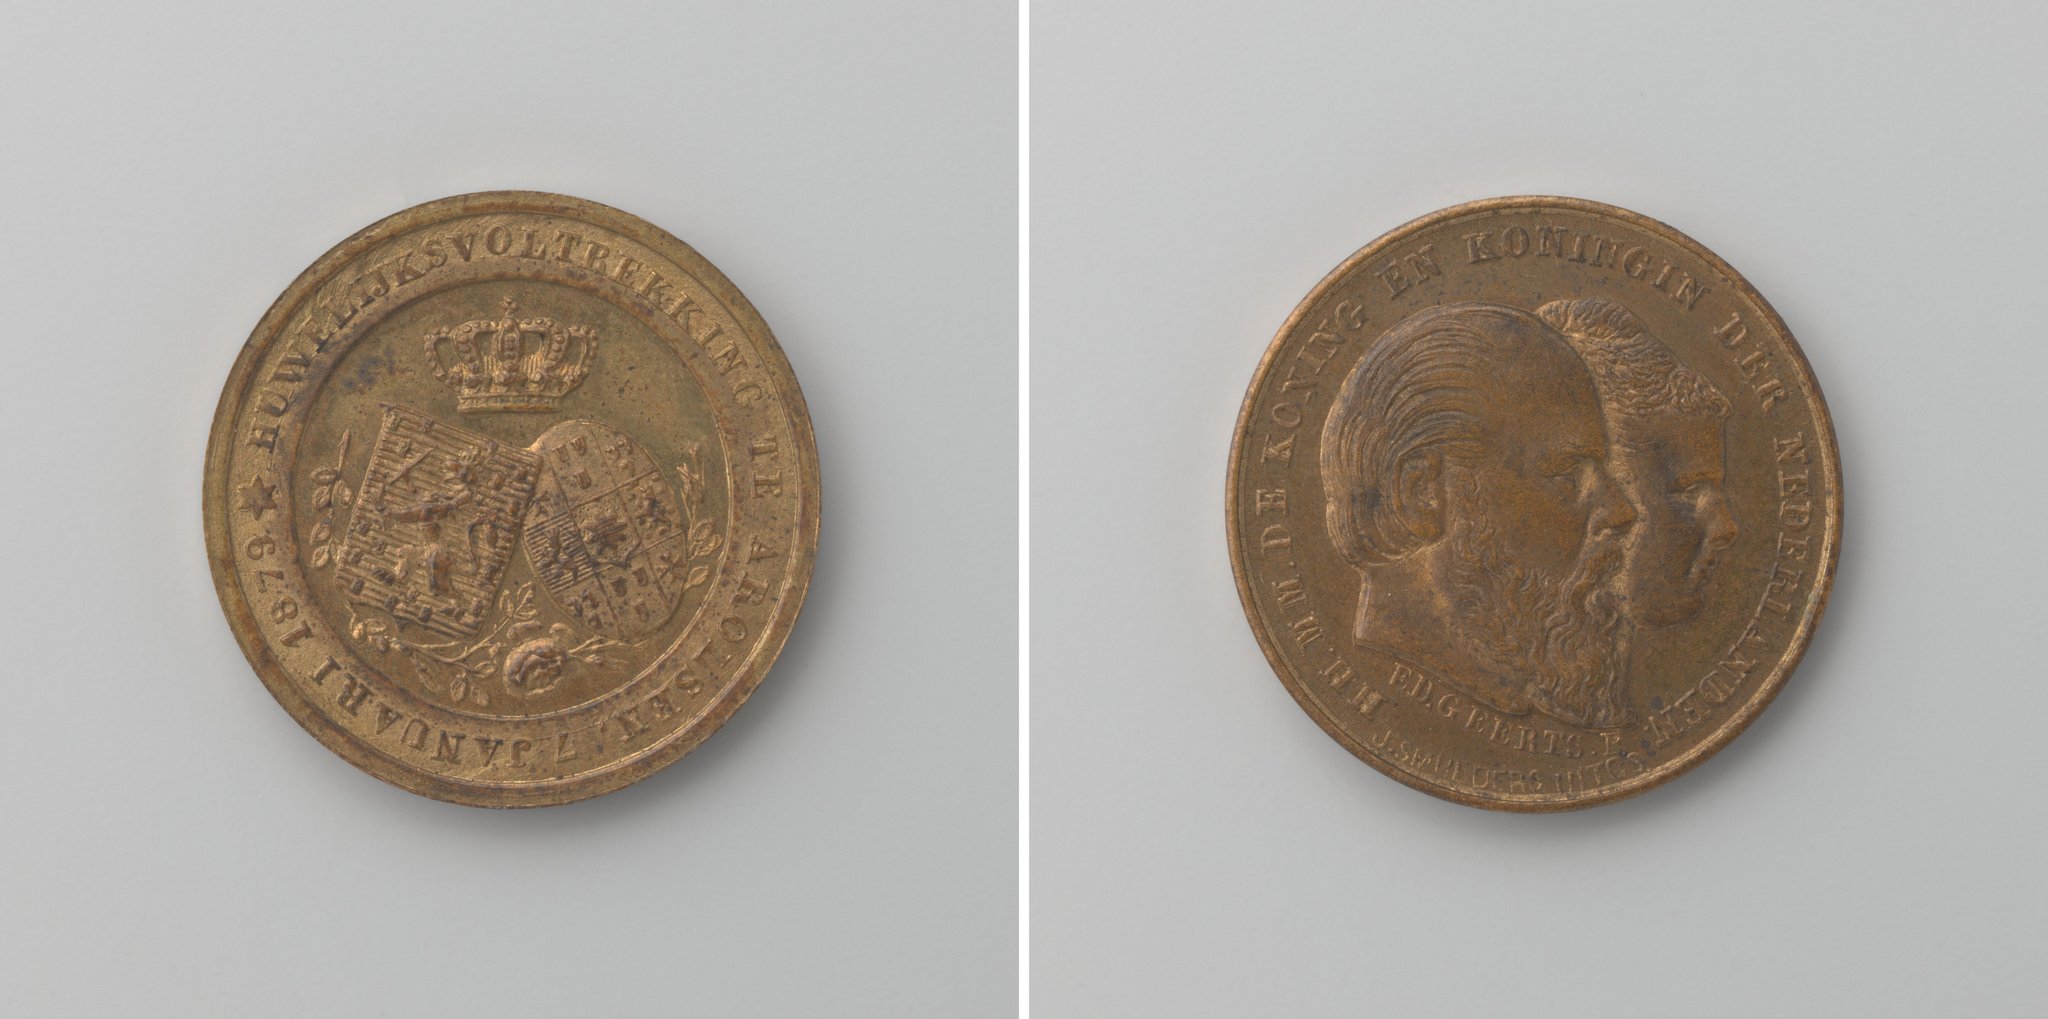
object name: history medal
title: Huwelijk van Koning Willem III met Emma van Waldeck-Pyrmont 1879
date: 1879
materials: brass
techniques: striking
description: Verguld messing penning, op de voorzijde de geconjugeerde bostbeelden van Willem III en Emma naar rechts met omschrift, op de keerzijde onder één kroon de wapenschilden van Nederland en Waldeck-Pyrmont op een rozentak, met omschrift.